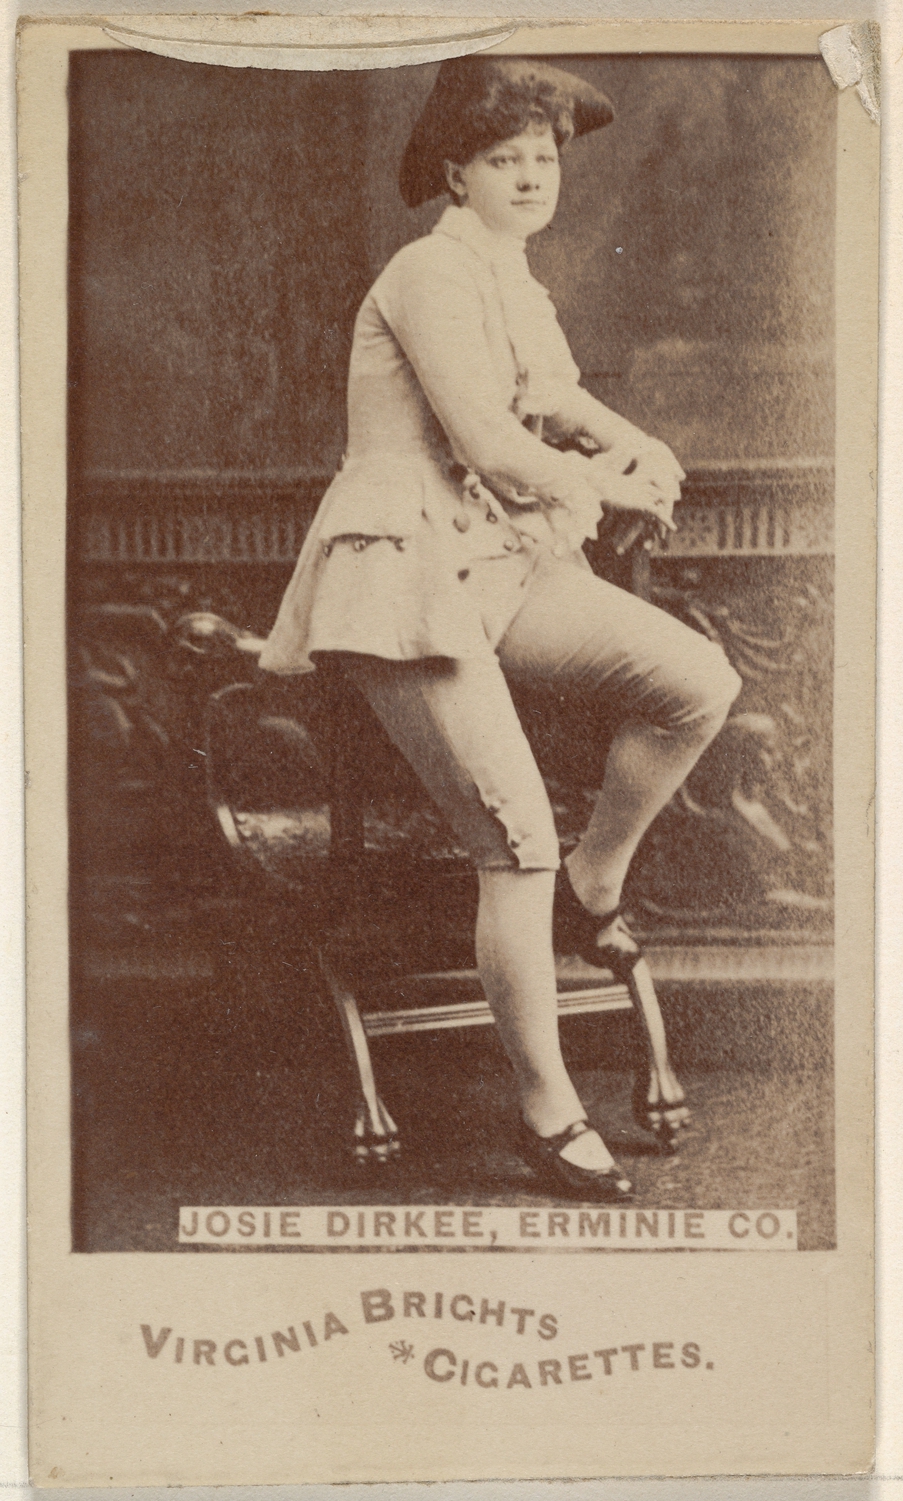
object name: photograph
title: Josie Dirkee, Erminie Co., from the Actors and Actresses series (N45, Type 6) for Virginia Brights Cigarettes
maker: allen & ginter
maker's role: publisher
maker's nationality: american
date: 1888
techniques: albumen silver print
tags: portraits,women,actresses